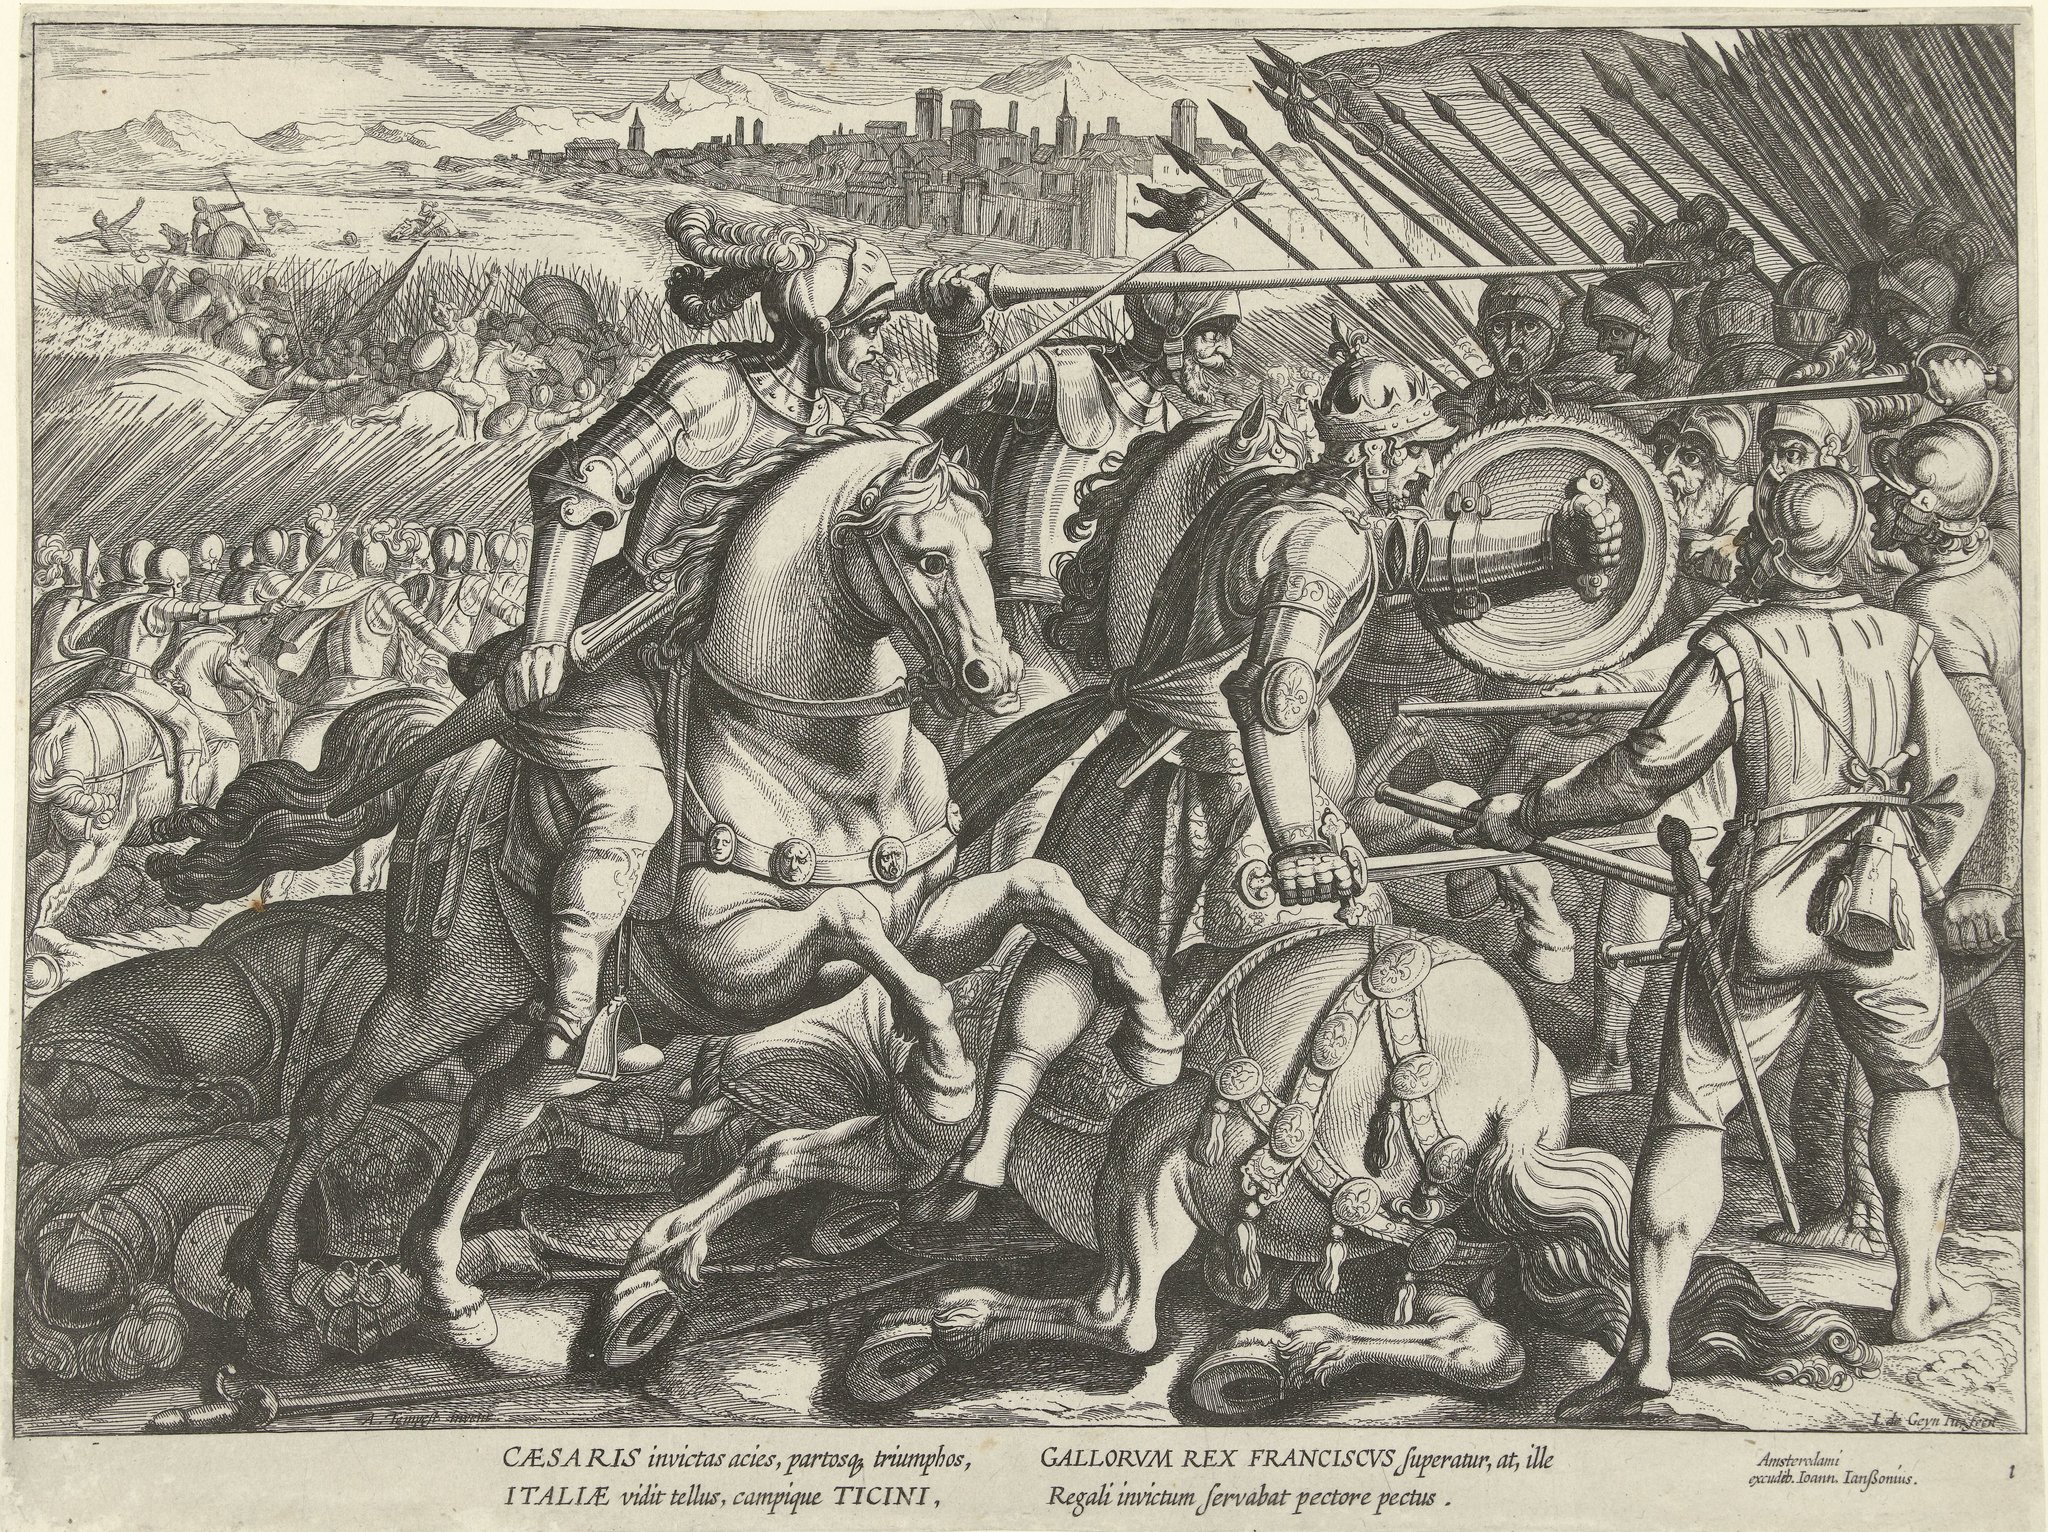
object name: history print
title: Overwinning van keizer Karel V op Frans I van Frankrijk bij Pavia, 1525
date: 1614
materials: paper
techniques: engraving, etching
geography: amsterdam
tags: frans i van valois-angoulême (koning van frankrijk), ghent, charles v (holy roman emperor and king of spain), battle (+ cavalry, horsemen)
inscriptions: collector's mark: Lugt 2228a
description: Overwinning van Karel V op Frans I, koning van Frankrijk in de slag bij Pavia in 1525. De soldaten van Karel V verslaan in gevecht de Franse soldaten. Rechts op de achtergrond een stad aan een kust. Met onderschrift van vier regels in het Latijn. Deze prent is onderdeel van een reeks van acht prenten, elk een triomf van Karel V voorstellende.